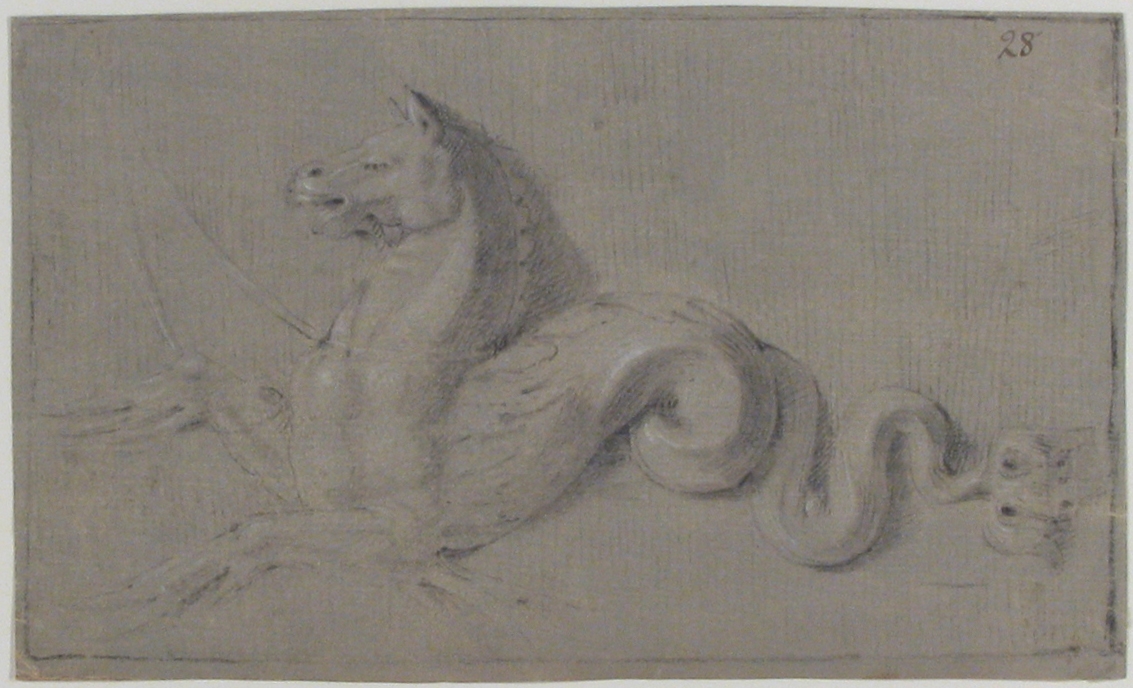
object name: drawing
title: Design for Sculpted Ornament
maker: anonymous, french, 19th century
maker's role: artist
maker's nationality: french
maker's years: 1800-1900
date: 1825-1850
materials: chalk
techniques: heightening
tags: sculpture